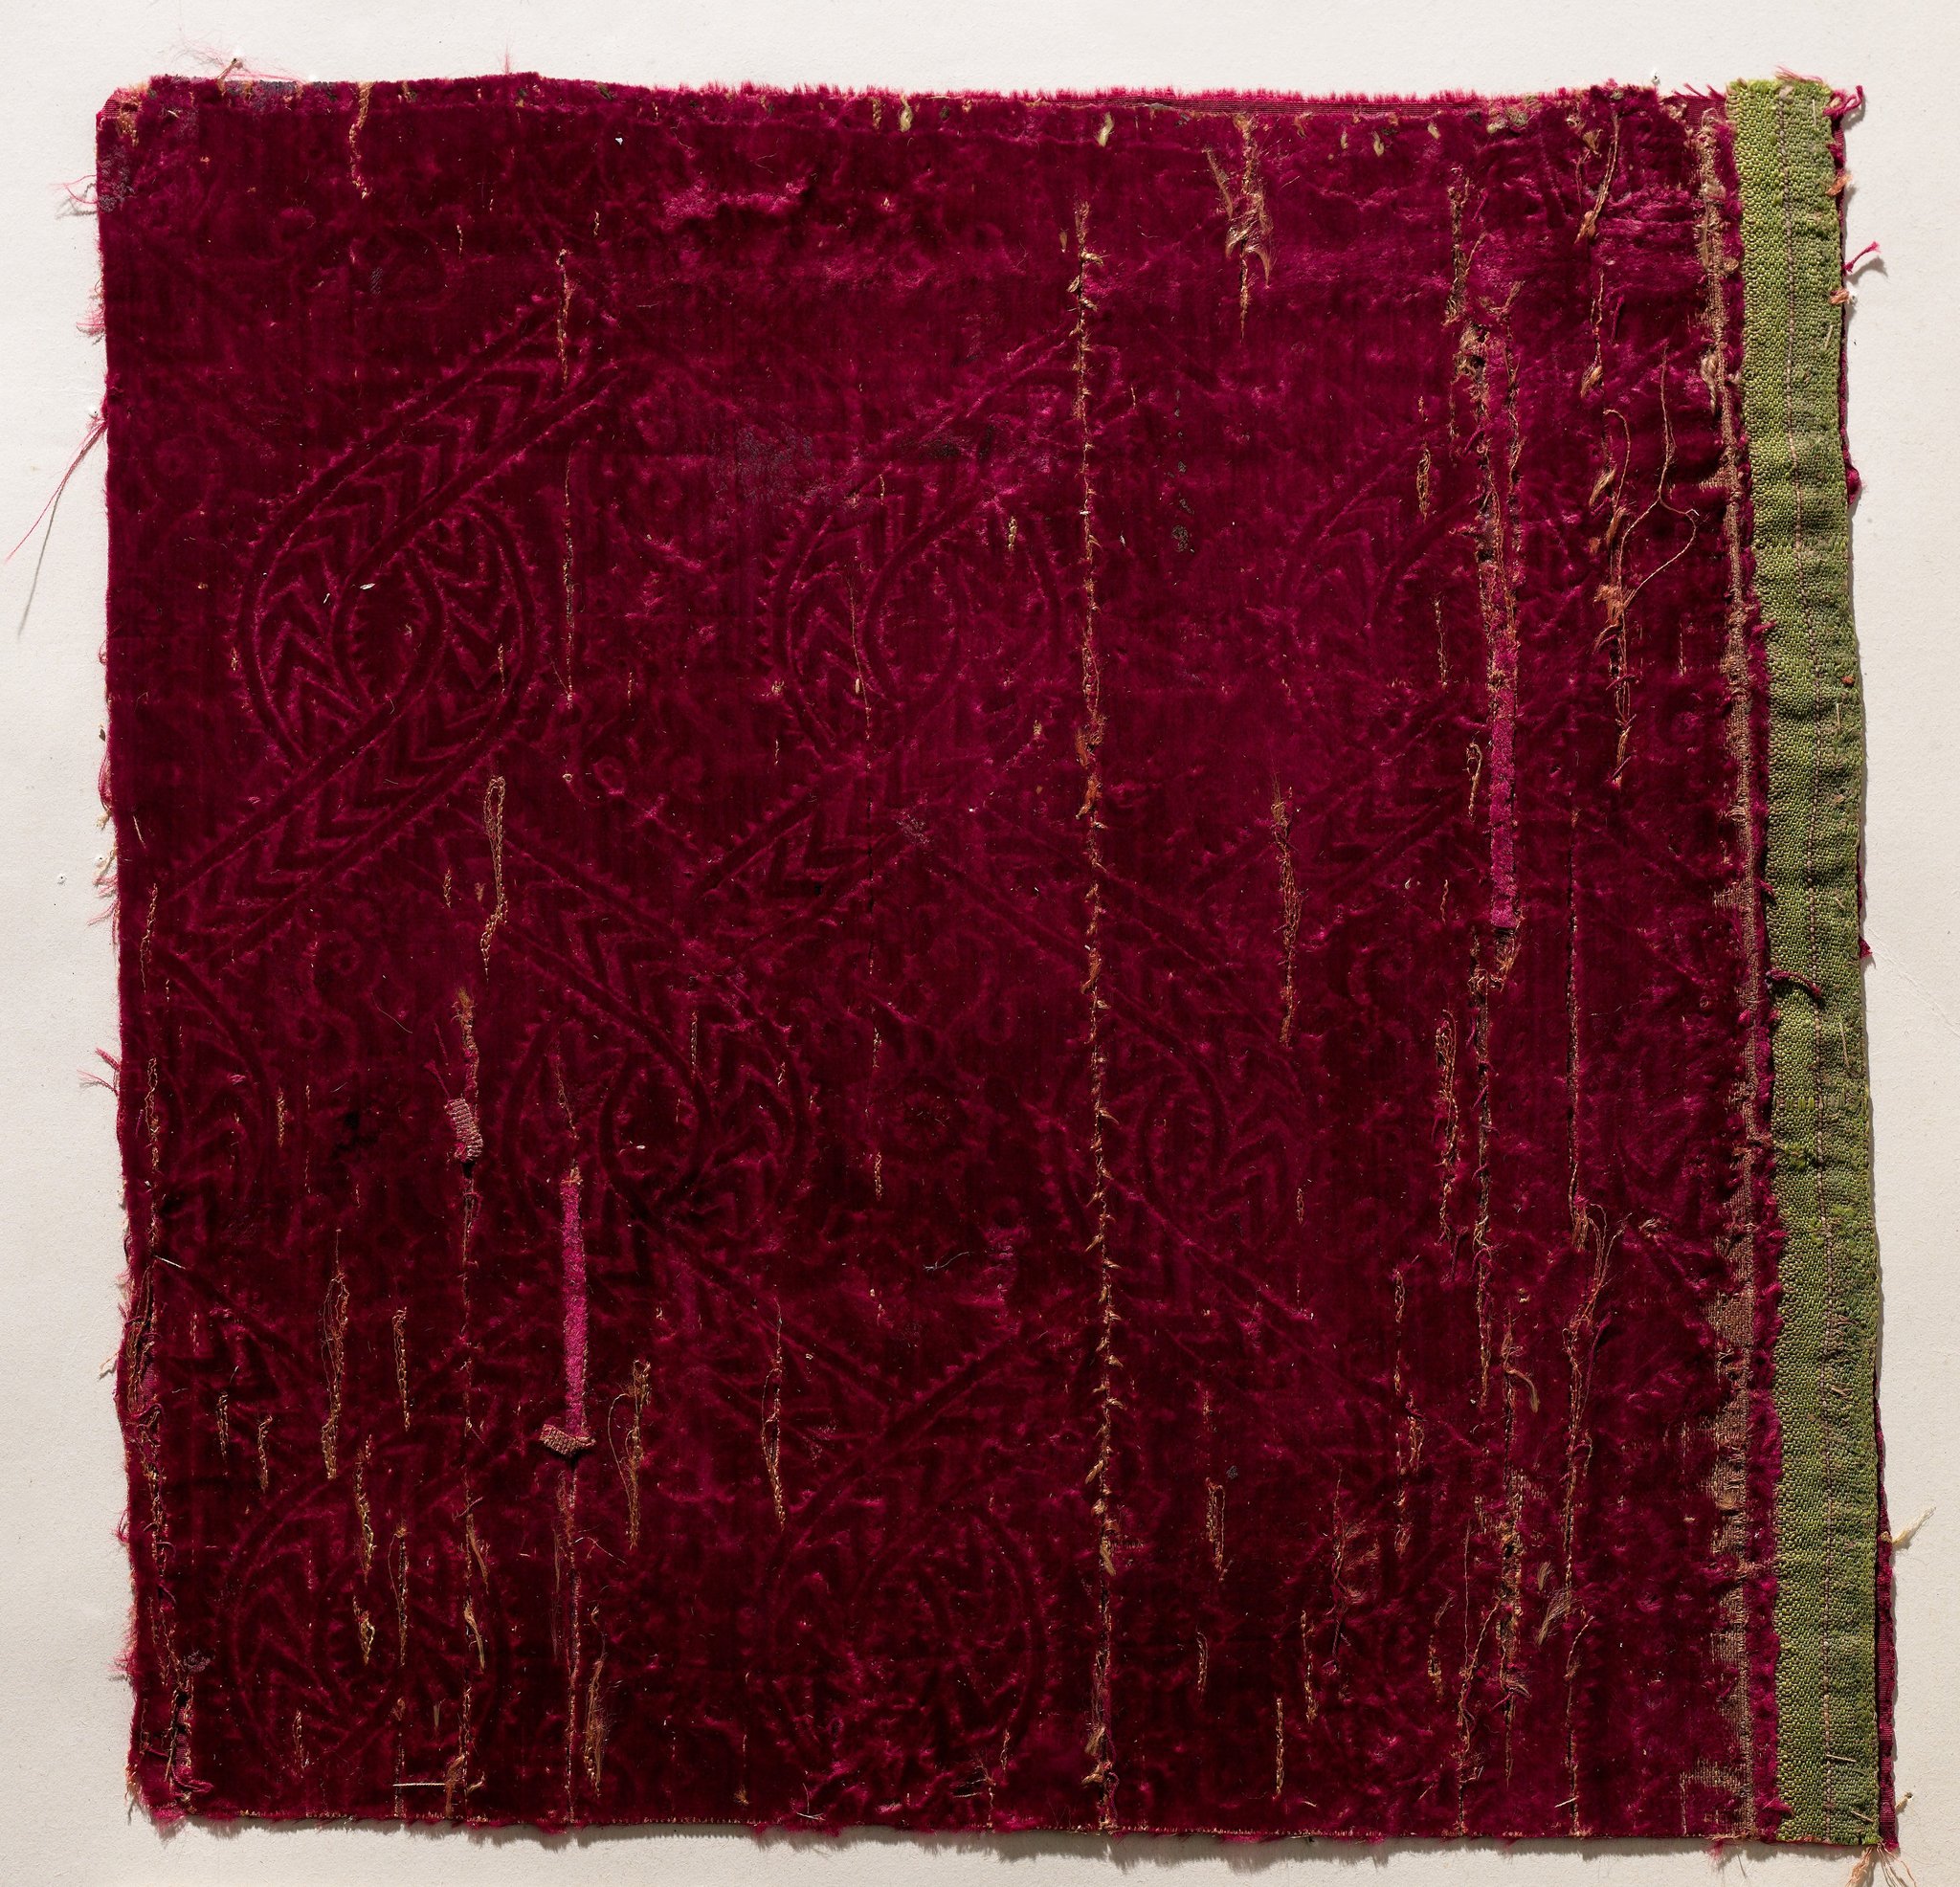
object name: fragment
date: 1601-1700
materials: silk